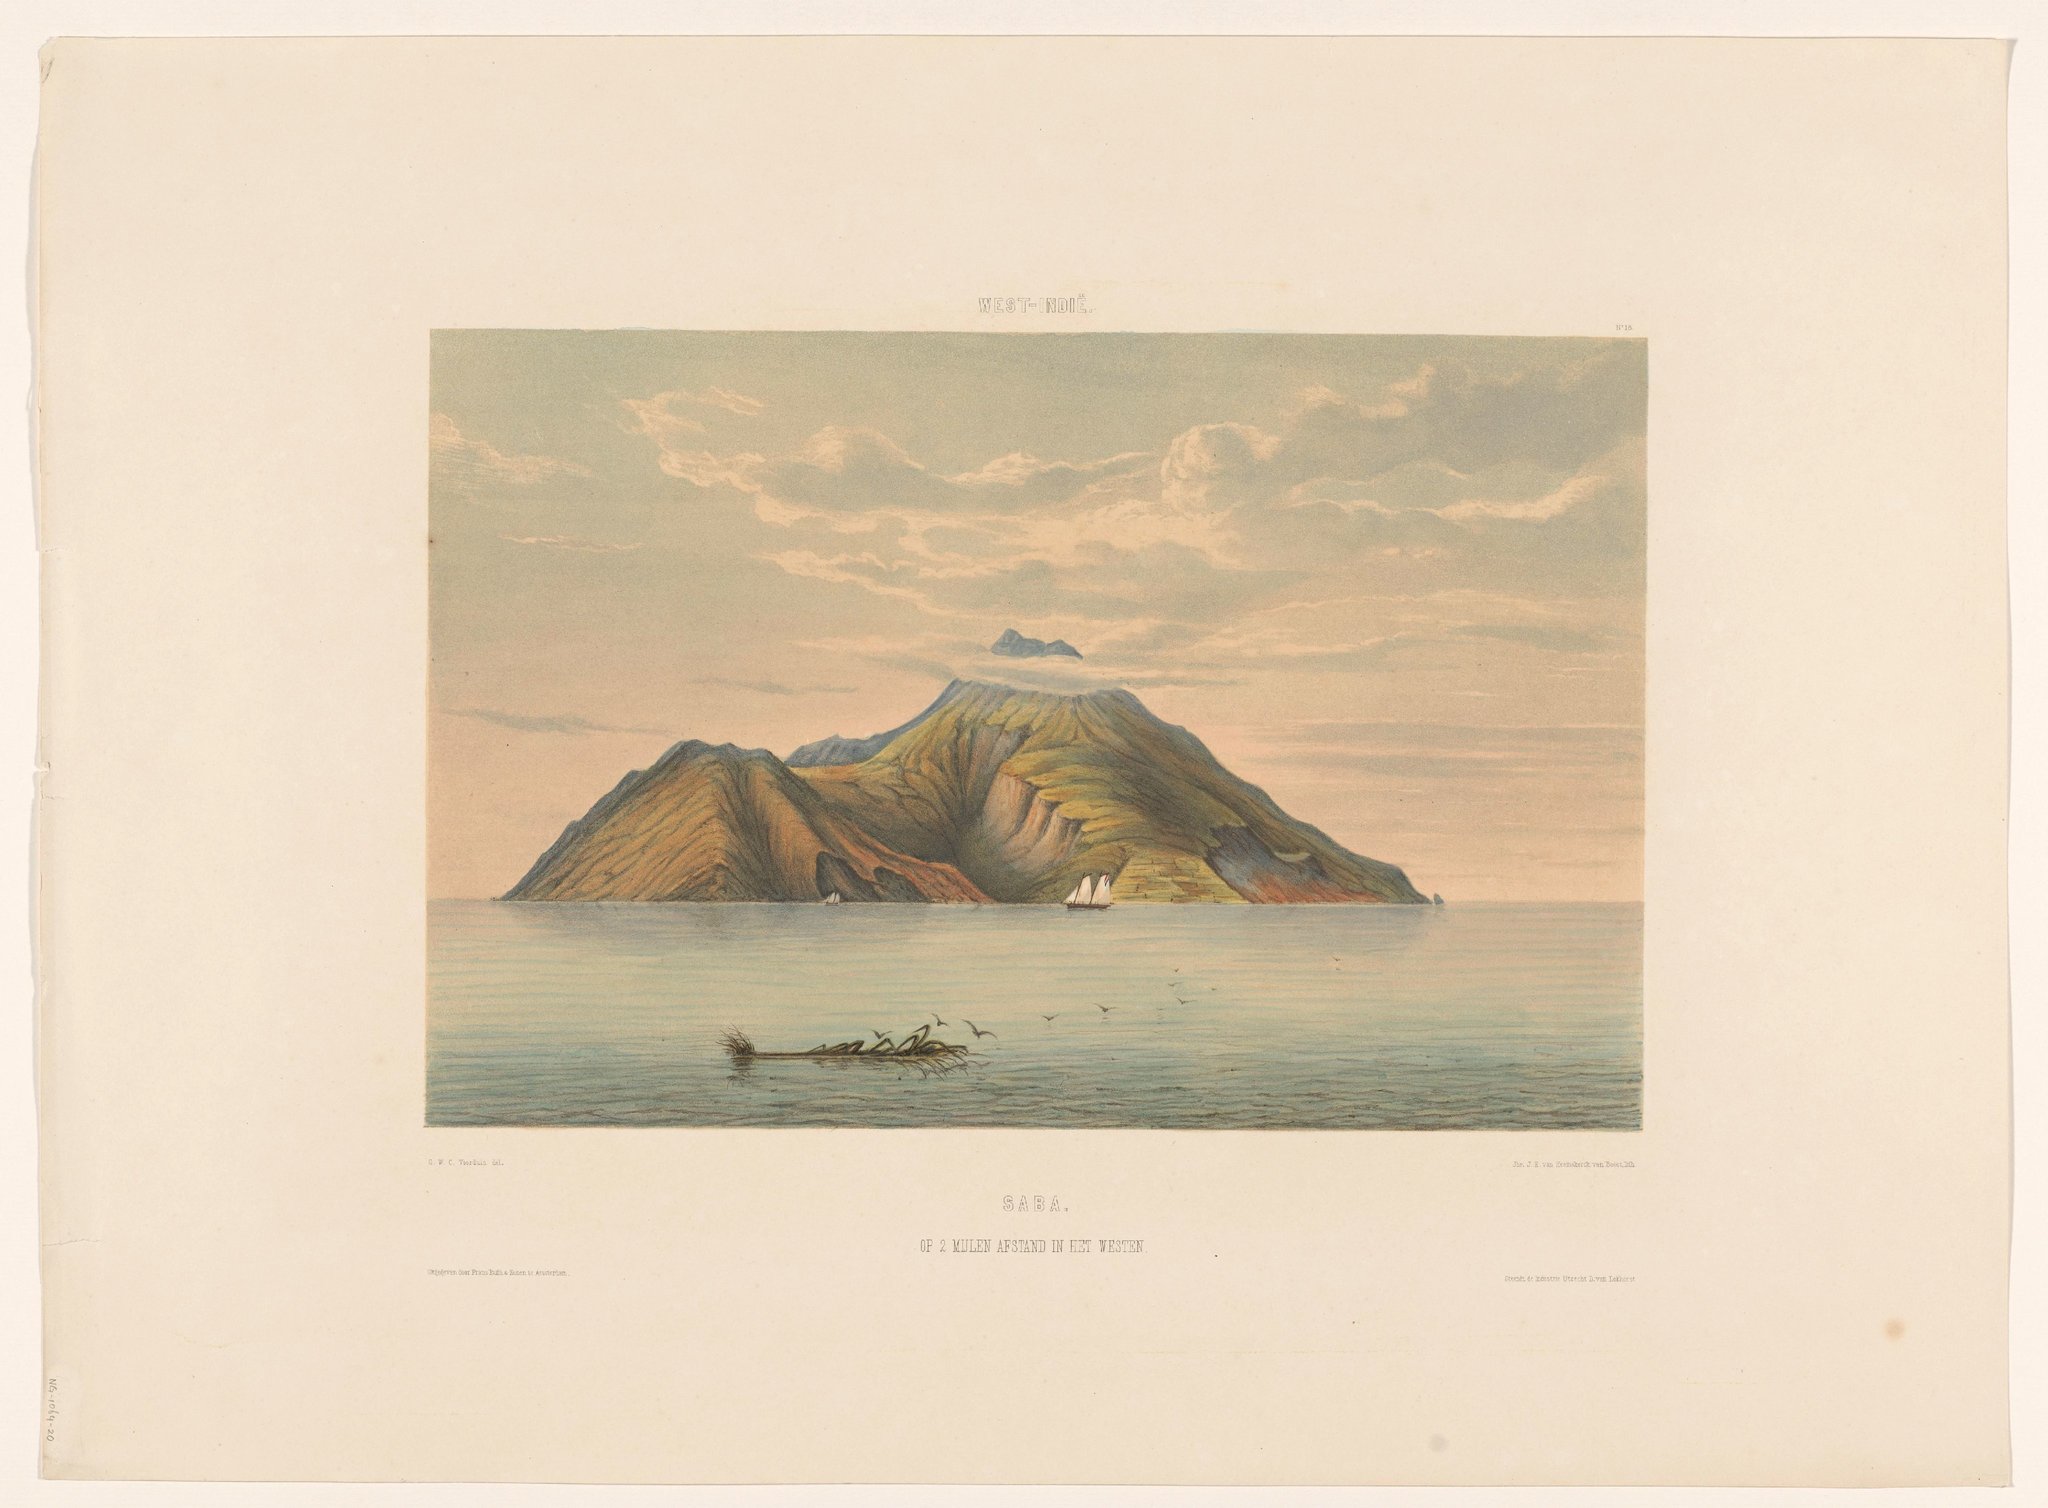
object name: print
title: Saba. Op 2 mijlen afstand in het westen.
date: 1860-1862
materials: paper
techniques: lithograph, hand coloring, lacquer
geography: netherlands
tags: colonial system, island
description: Gezicht op het eiland Saba. Onderdeel van het plaatwerk 'Gezigten uit Neerland's West-Indien'.